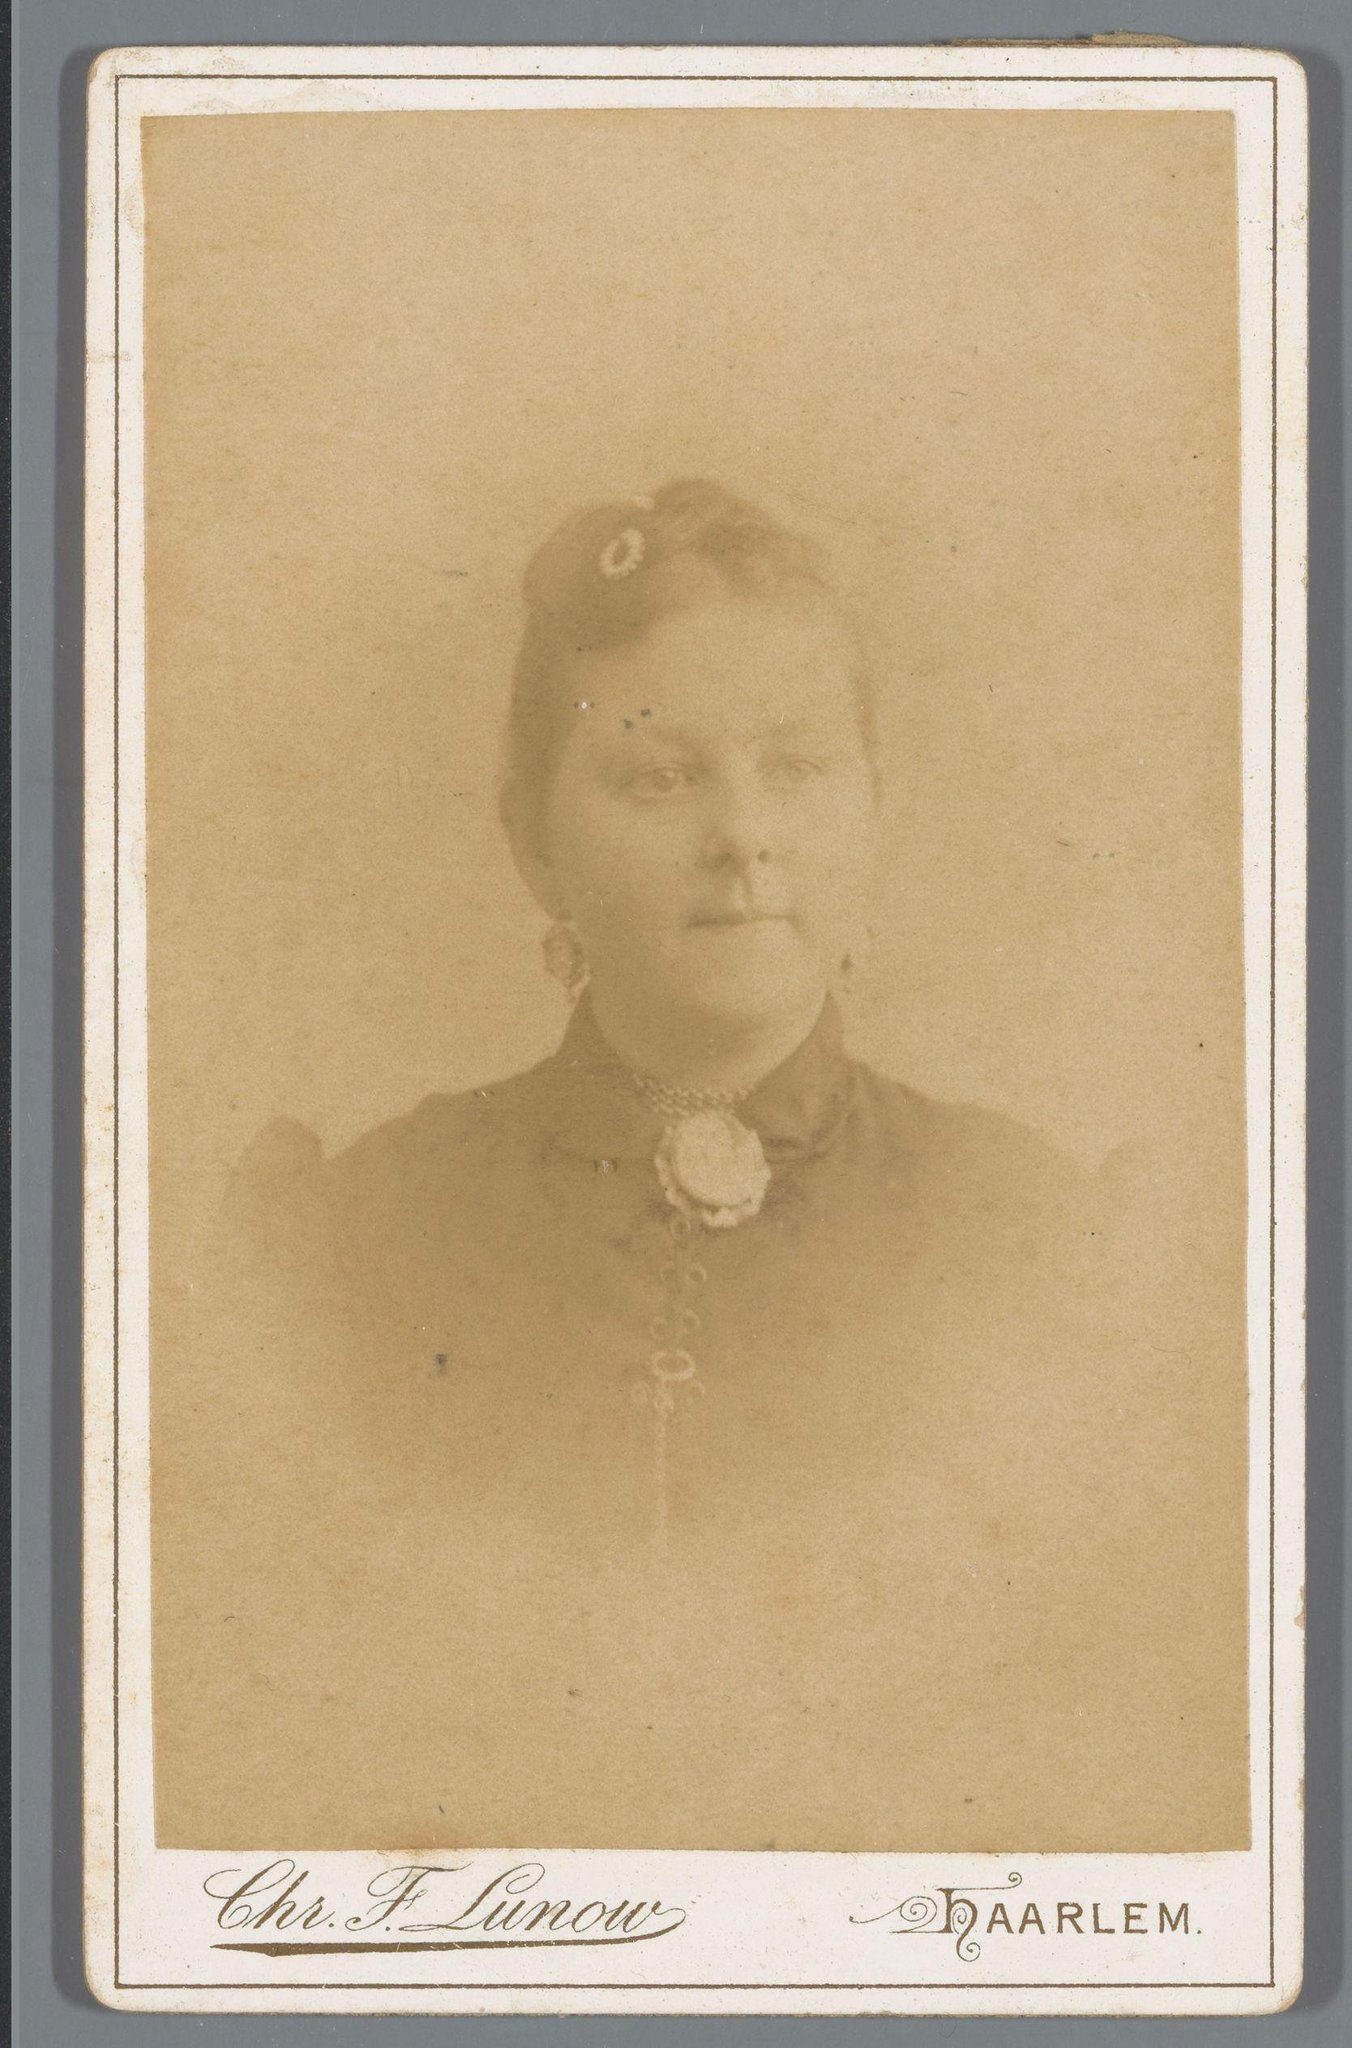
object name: carte de visite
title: Portret van een onbekende vrouw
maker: fredrich christiaan lünow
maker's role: fotograaf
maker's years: 1857-1925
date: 1888-1899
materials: cardboard, paper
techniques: albumen print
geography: haarlem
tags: adult woman, anonymous historical person portrayed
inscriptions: name: ‘ALEX:LINDNER BERLIN.’, address: ‘Haarlem/ Barteljoresstraat 17.’